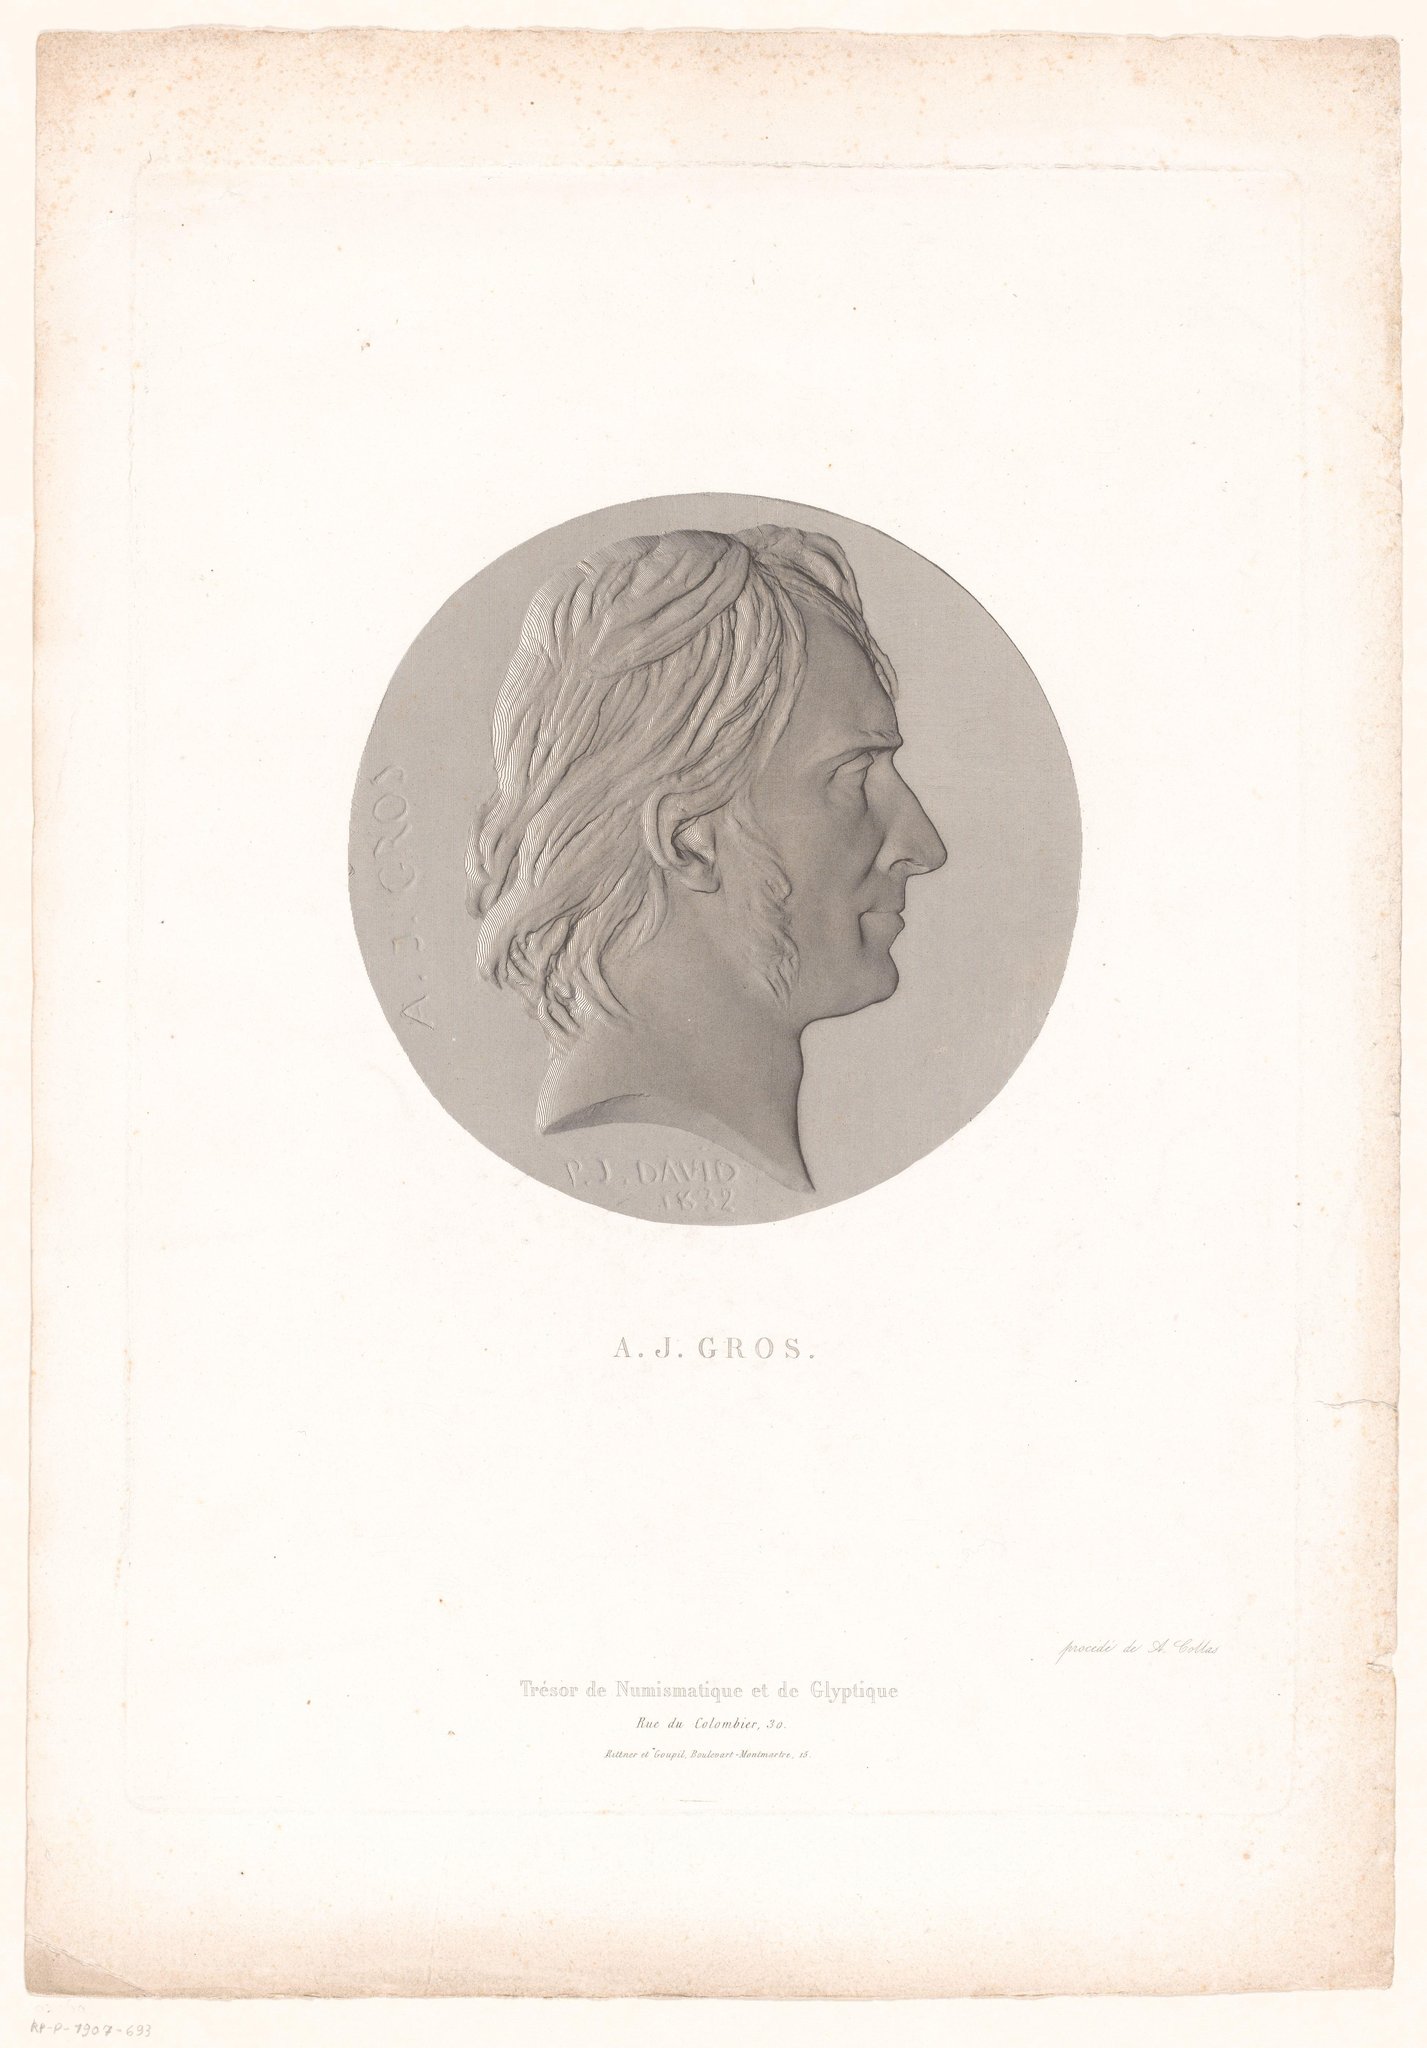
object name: print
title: A.J. Gros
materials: paper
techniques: relief engraving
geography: paris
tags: paris, painter, print maker, antoine-jean gros, ornament ~ medallion, historical persons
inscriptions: collector's mark: Lugt 2228